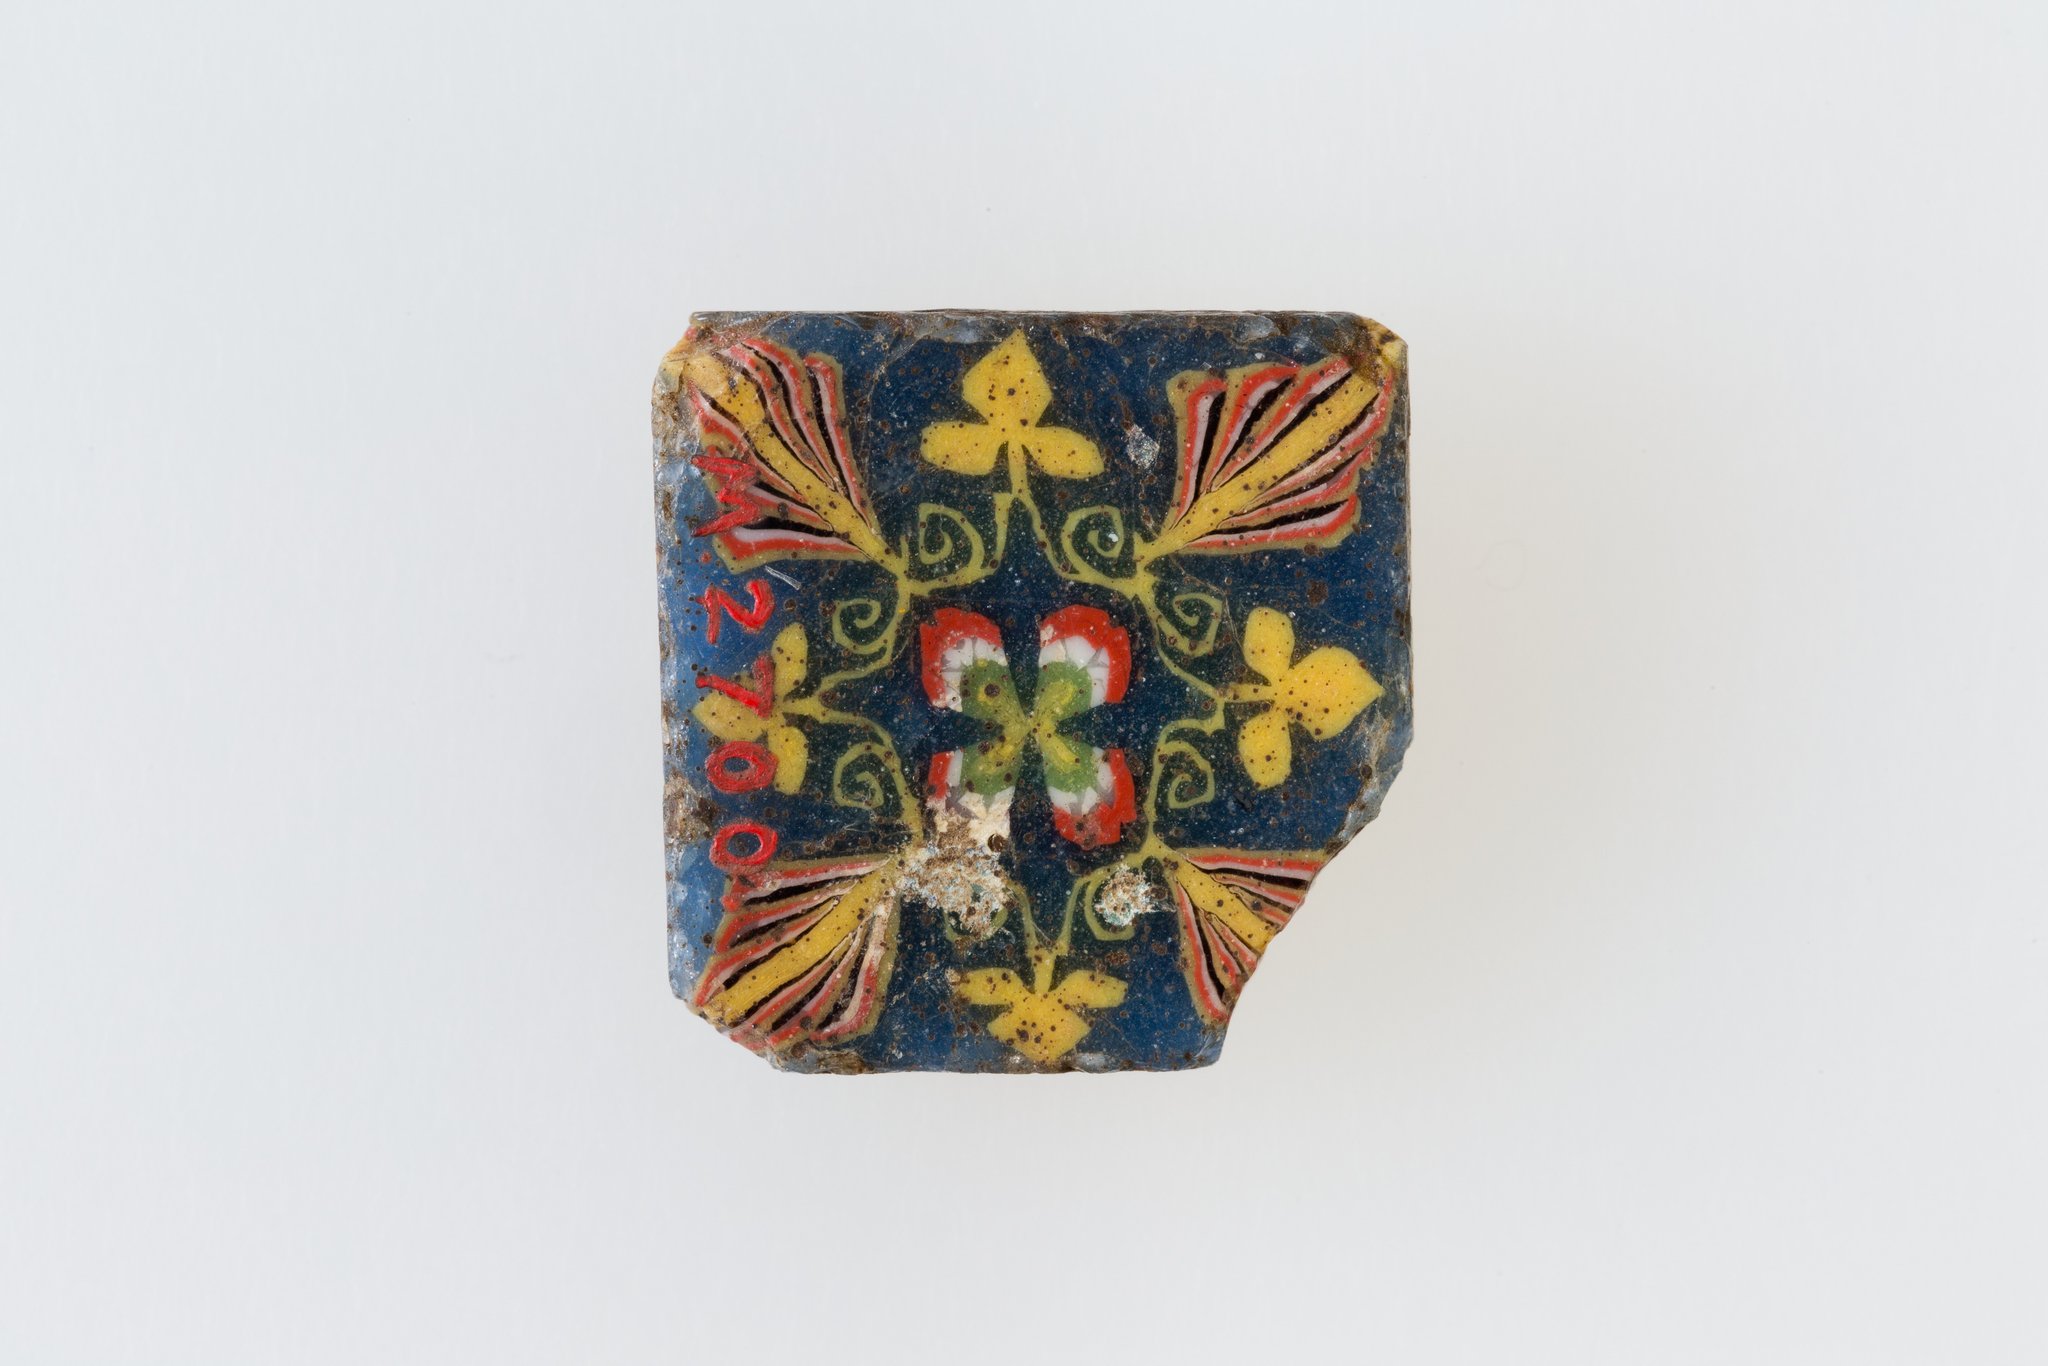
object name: inlay, square, floral design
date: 1-300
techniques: mosaic glass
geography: egypt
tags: flowers